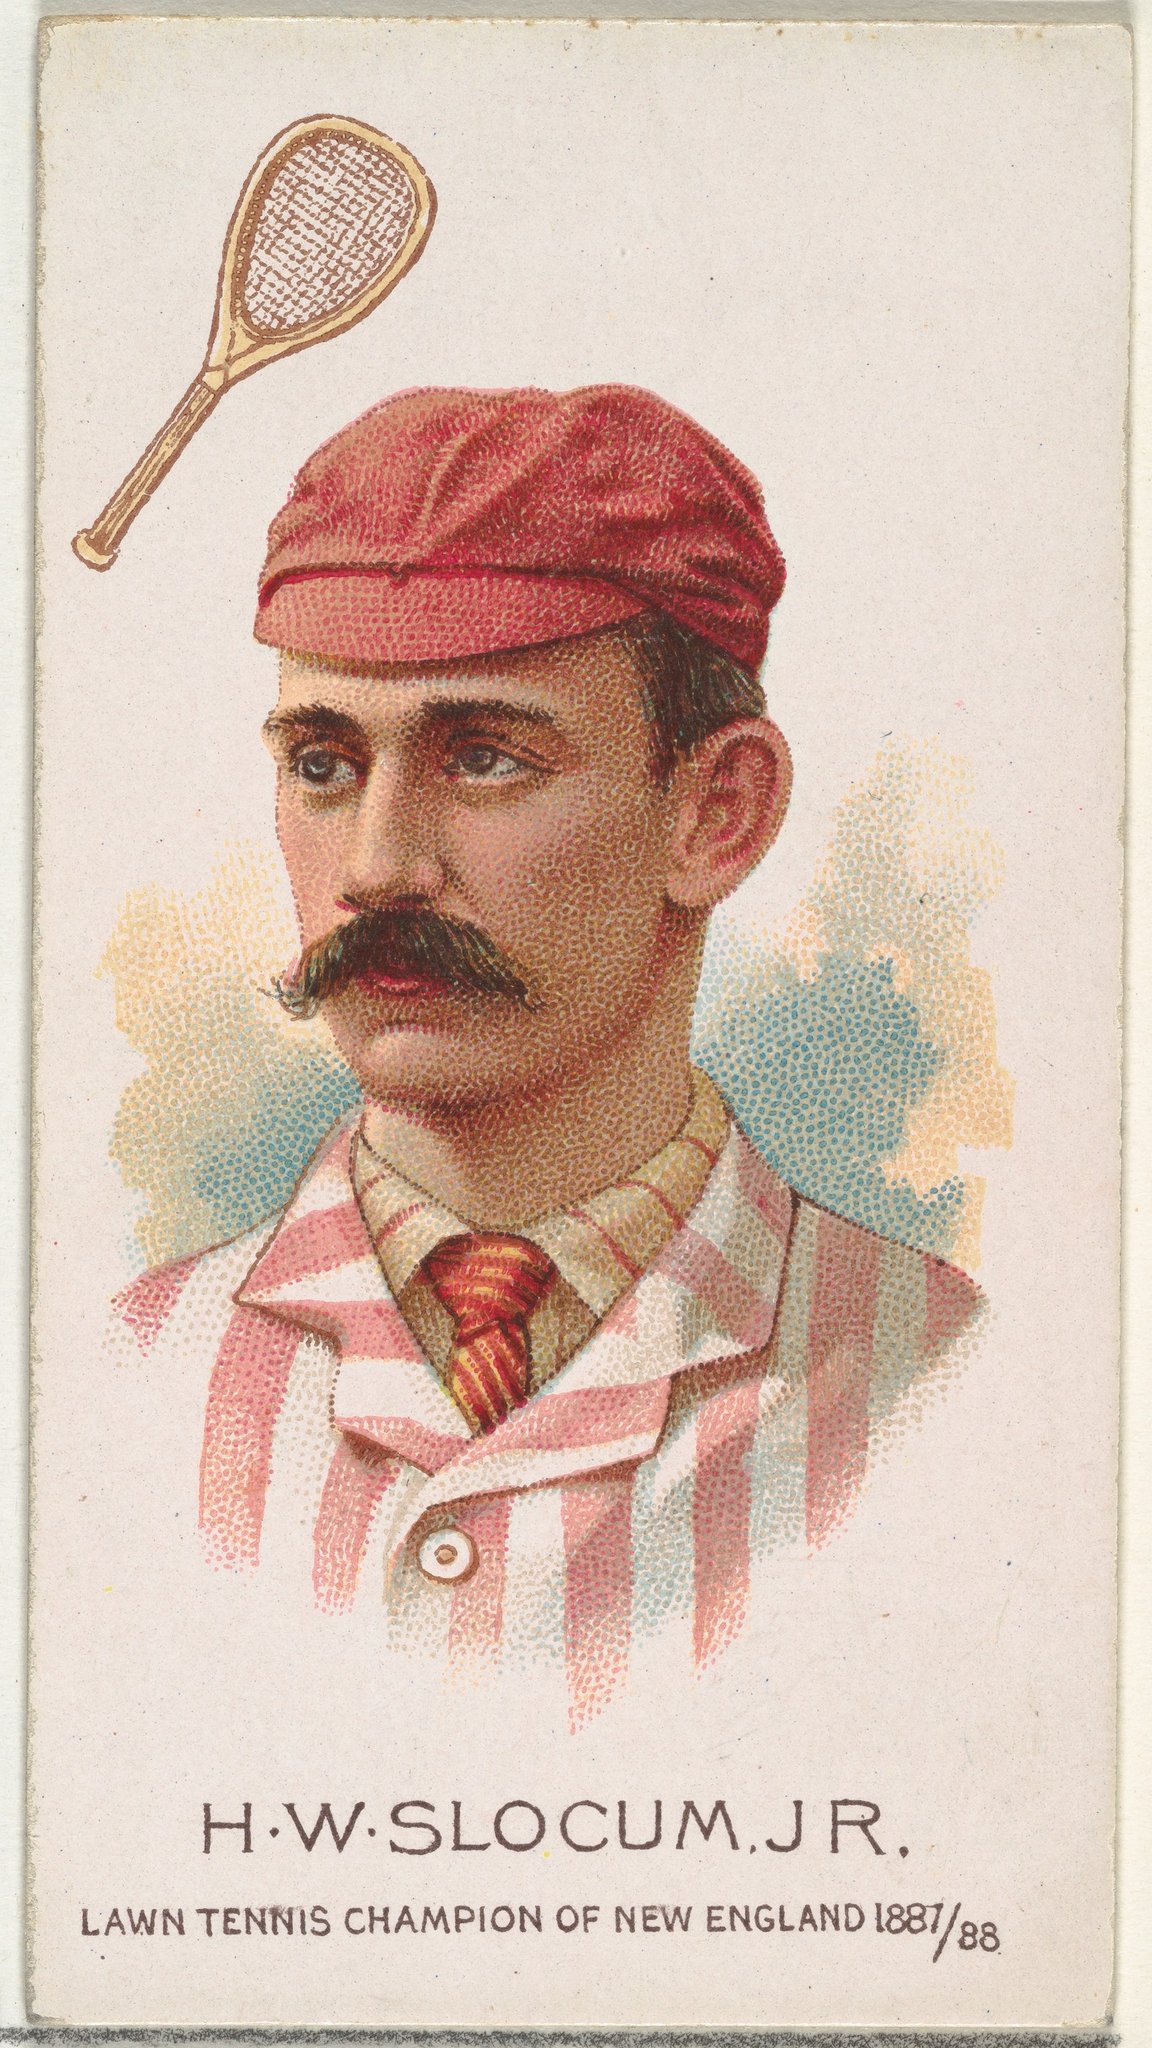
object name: print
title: H.W. Slocum, Jr., Lawn Tennis Champion of New England 1887/88, from World's Champions, Series 2 (N29) for Allen & Ginter Cigarettes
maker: allen & ginter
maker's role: publisher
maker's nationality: american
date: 1888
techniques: color lithograph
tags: men,portraits,athletes